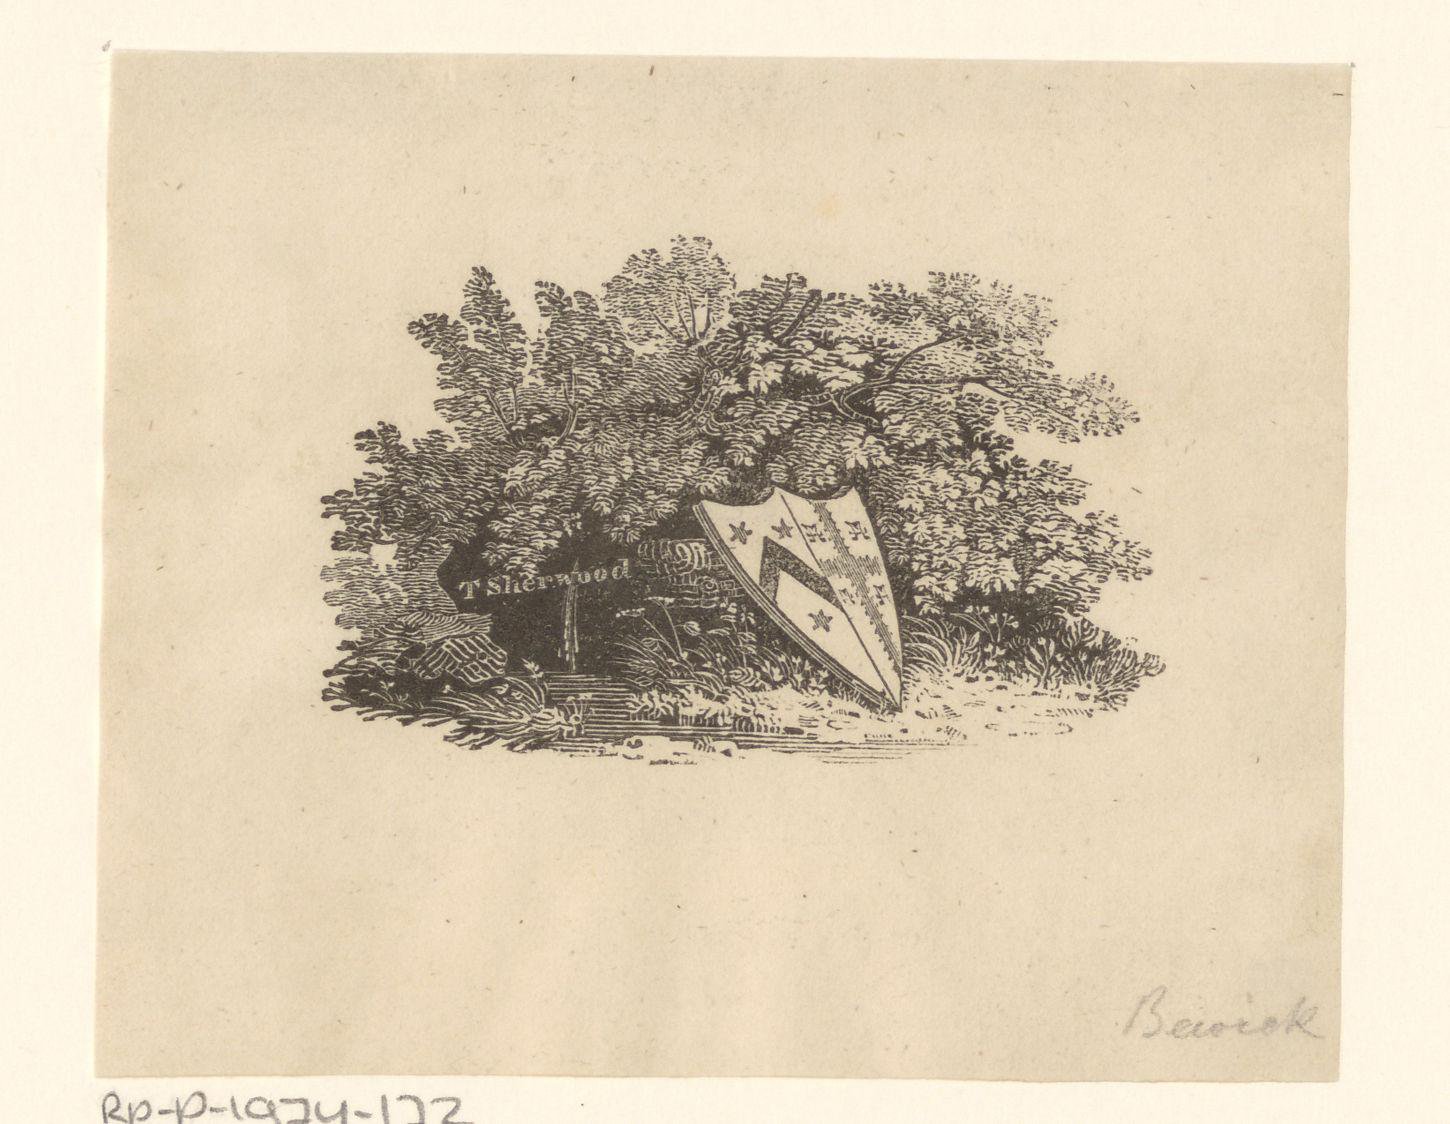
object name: bookplate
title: Ex libris van T. Sherwood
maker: thomas bewick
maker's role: draughtsman, painter, print maker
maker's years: 1753-1828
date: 1768-1828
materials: paper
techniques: engraving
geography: great britain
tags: shrubs, armorial bearing, heraldry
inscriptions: collector's mark: Lugt 2228